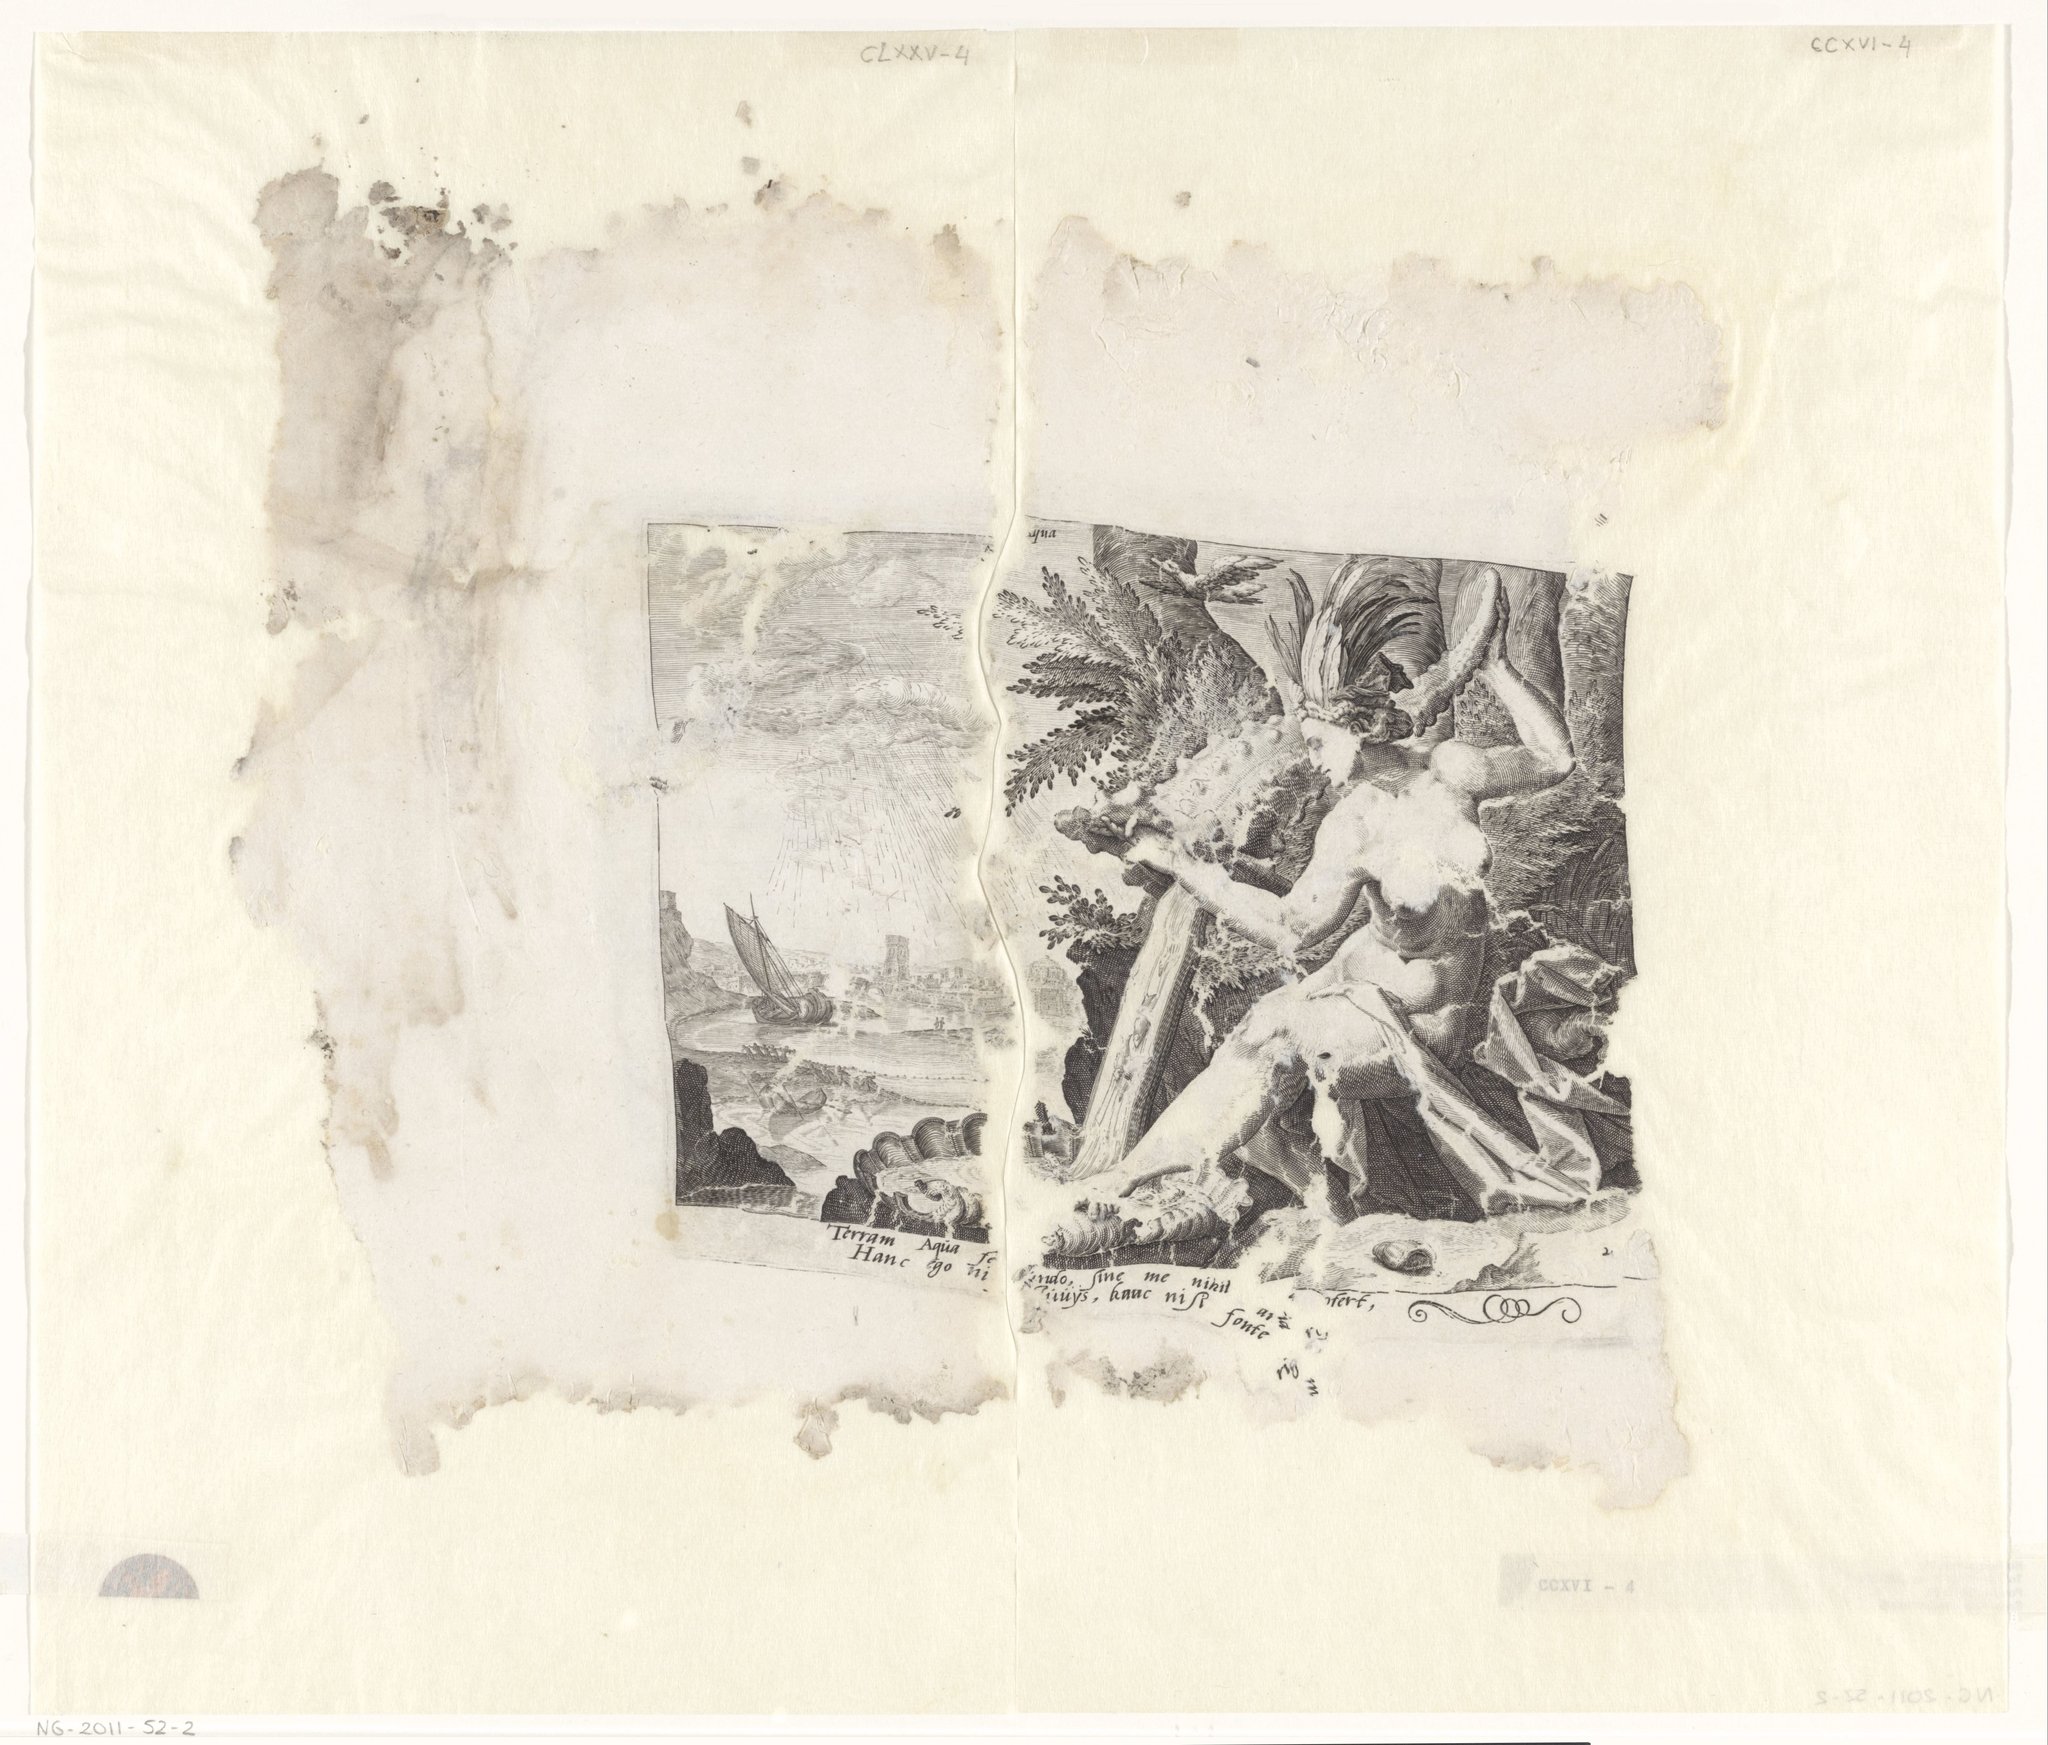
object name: print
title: Vier elementen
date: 1580-1596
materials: paper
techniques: engraving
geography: amsterdam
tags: water (one of the four elements)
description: De prenten in de Nova Zembla collectie zijn tijdens een expeditie van Willem Barendsz en Jacob van Heemskerk in 1596-1597 noodgedwongen in het winterkamp, het ‘Behouden Huis’, op het eiland achtergelaten. De prenten waren in één of meerdere stapels als handelswaar meegenomen vanuit Amsterdam. Bijna drie eeuwen later, in 1871, keerde de Noor Elling Carlsen terug naar Nova Zembla en vond daar de restanten van het ‘Behouden Huis, inclusief een groot deel van de inventaris. Een deel van de prenten, in de vorm van aaneengekoekte kluiten, werd toen ook teruggevonden. De papierkluiten waren soms op meerdere plekken gebroken. Tussen 1975-1979 zijn de prenten van elkaar gescheiden. Dit leverde in totaal ca. 1000 fragmenten van ca. 400 afdrukken van ca. 150 verschillende prenten op. Voor zover mogelijk zijn de fragmenten samengevoegd en zijn de prenten gereconstrueerd.